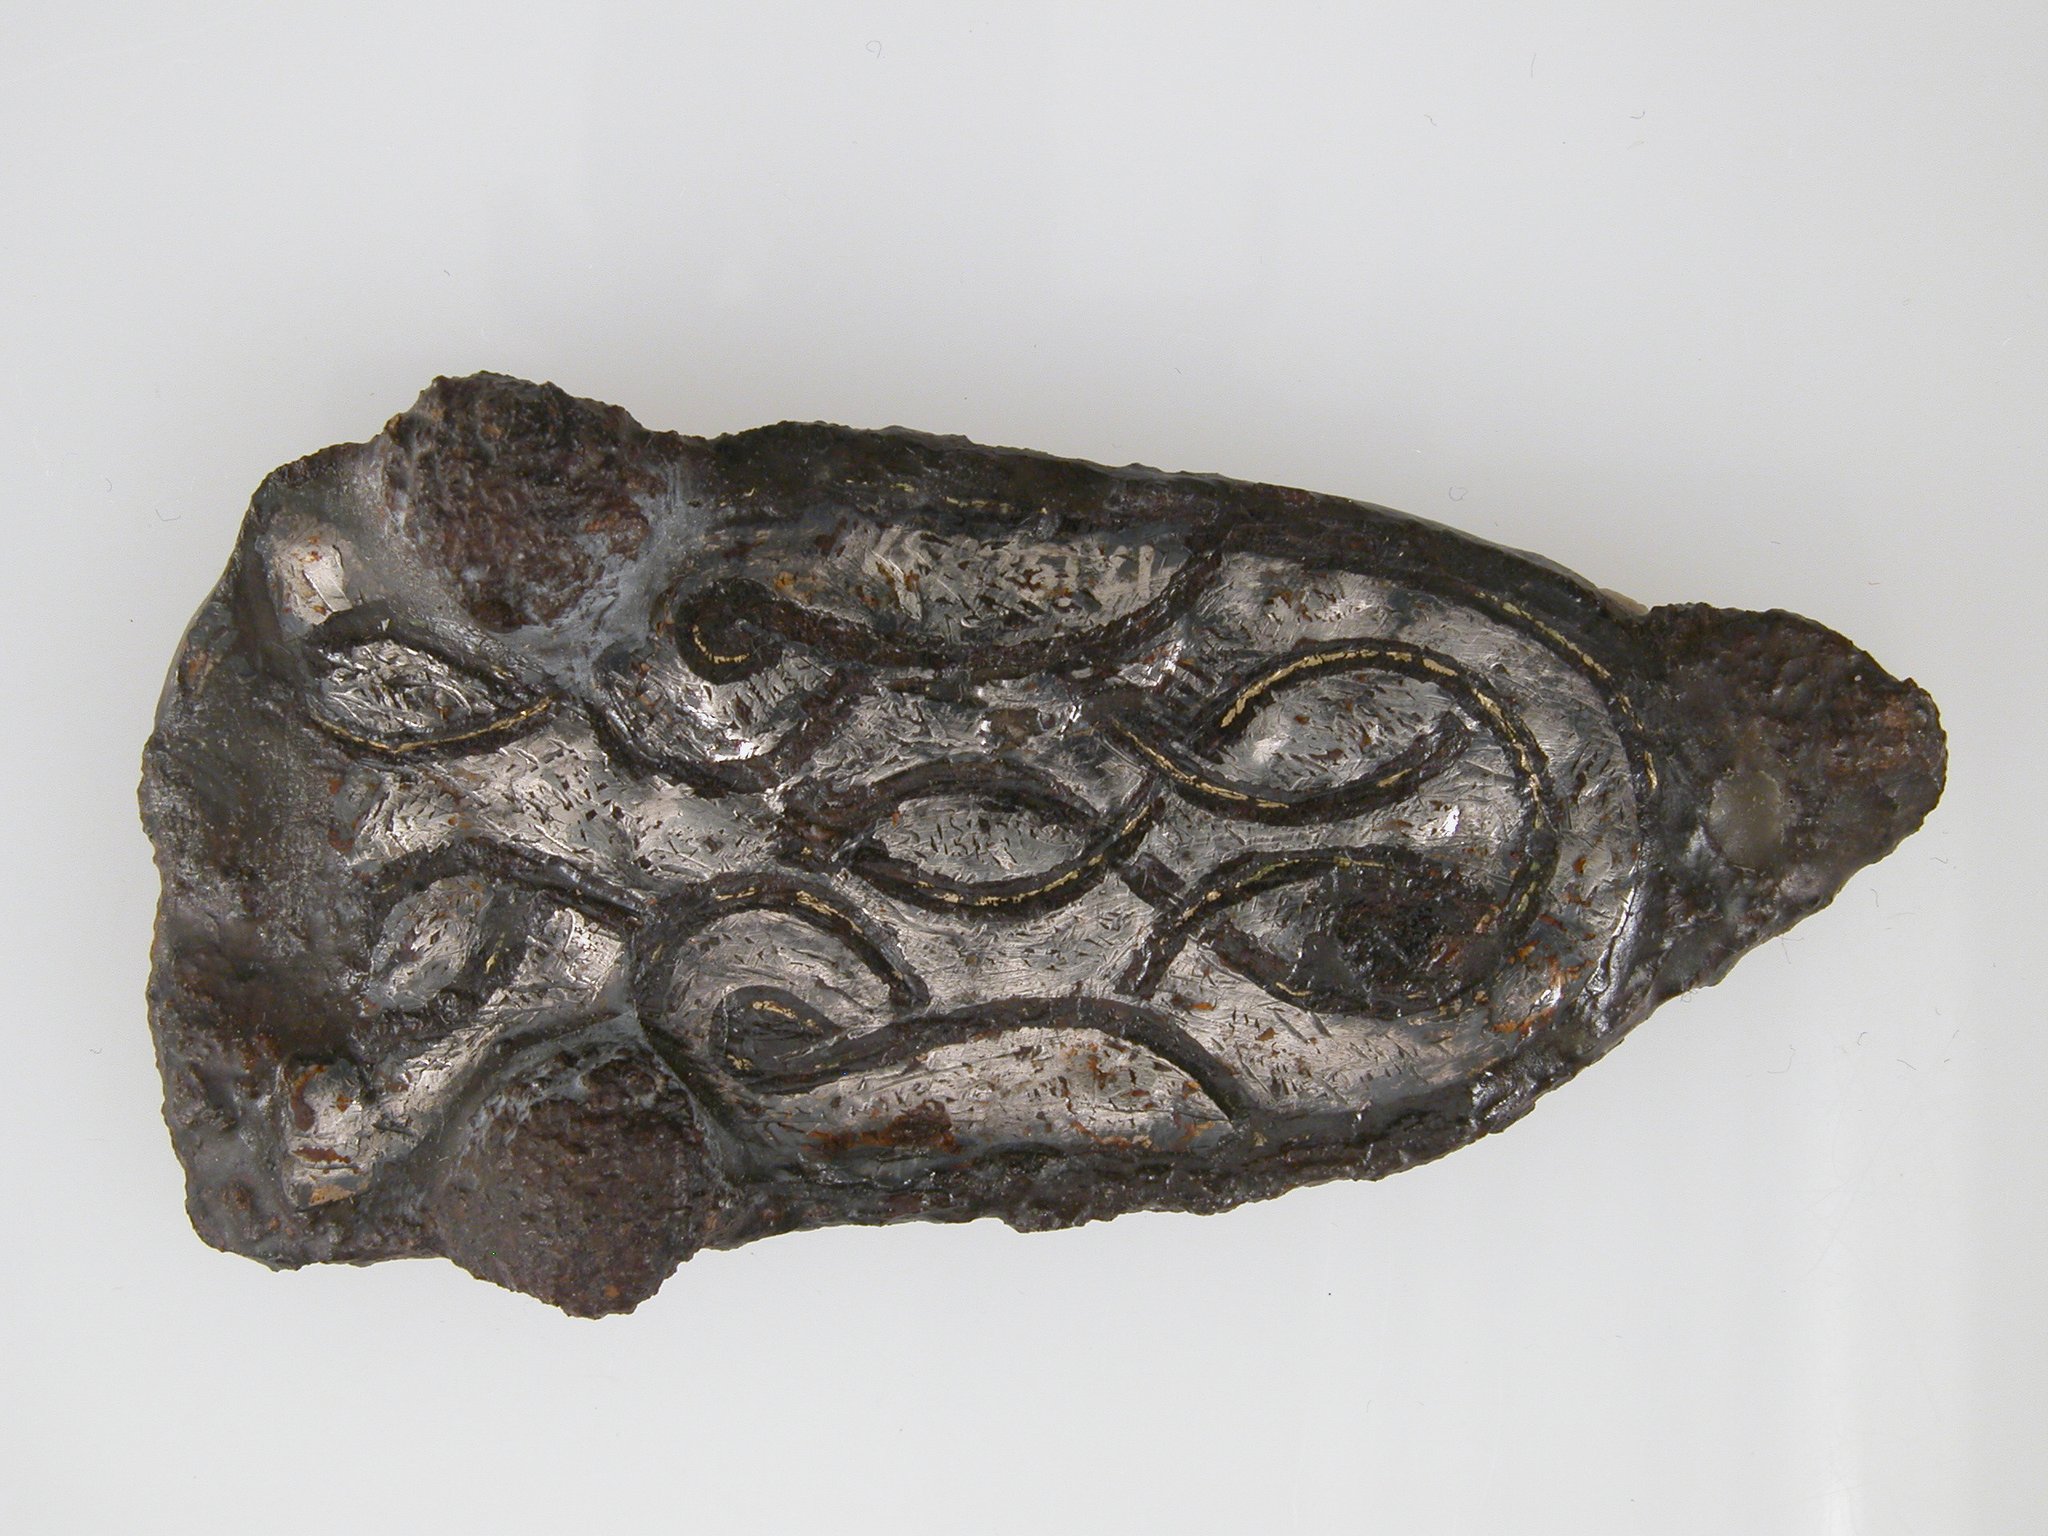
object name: buckle plate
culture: frankish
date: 301-700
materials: brass, gold, iron, silver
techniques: inlay